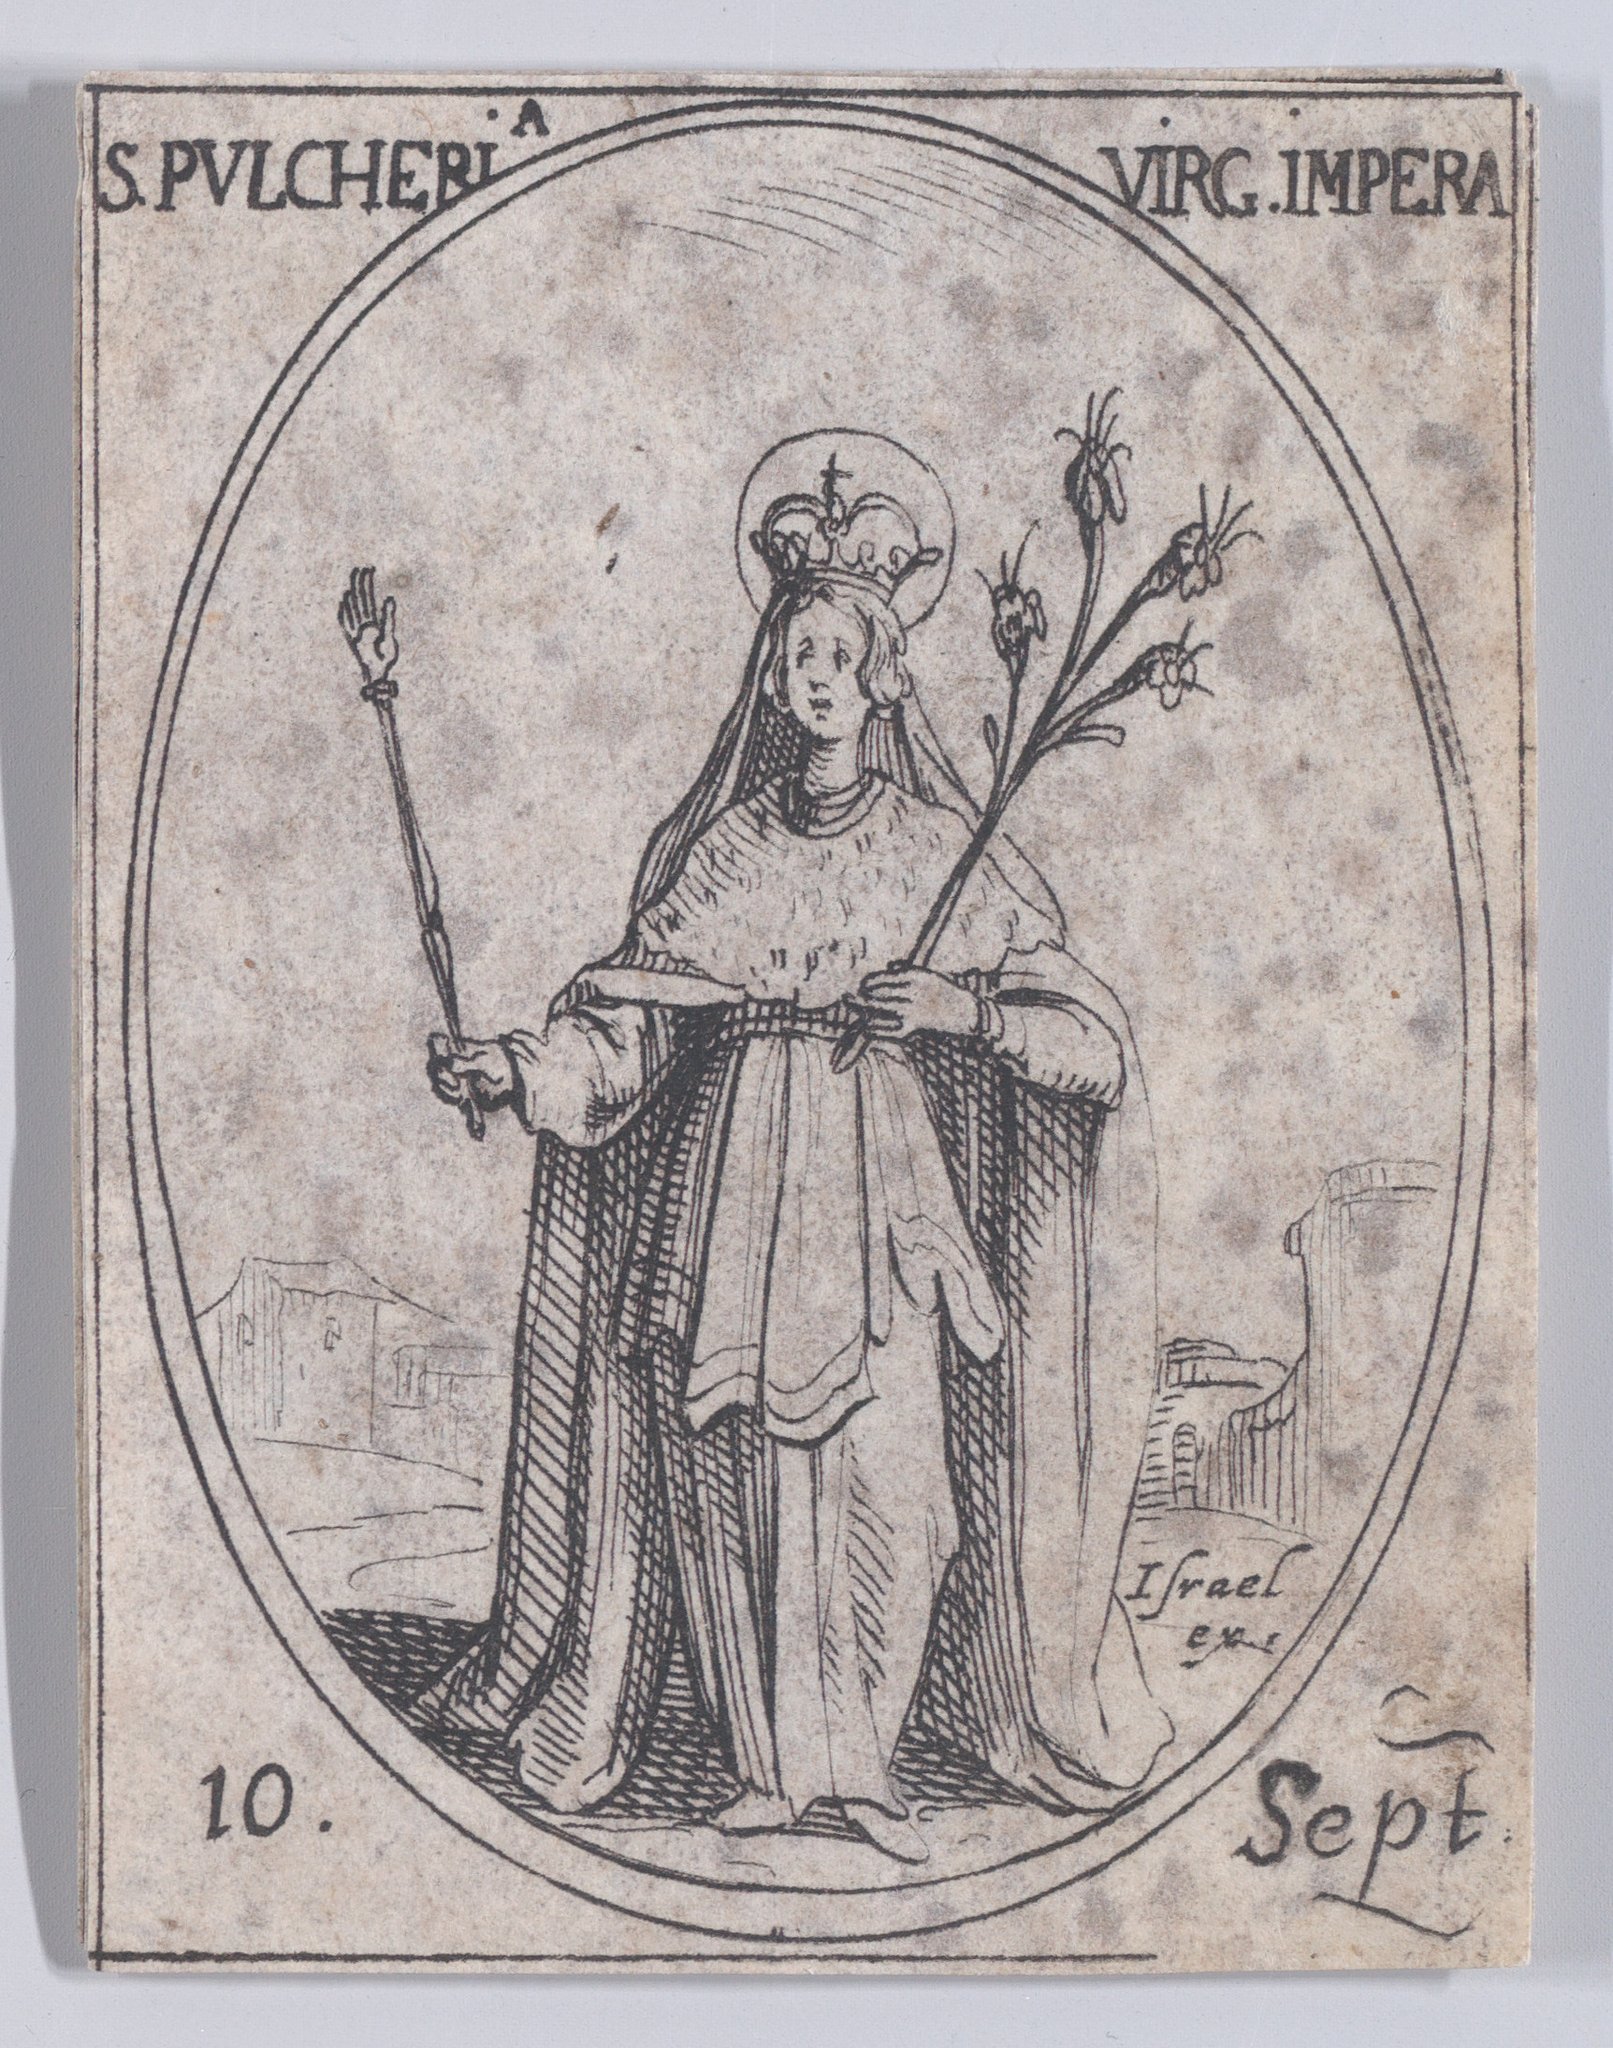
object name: print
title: Ste. Pulchérie, impératrice et vierge (St. Pulcheria, Empress and Virgin), September 10th, from "Les Images De Tous Les Saincts et Saintes de L'Année" (Images of All of the Saints and Religious Events of the Year)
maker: jacques callot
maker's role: artist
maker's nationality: french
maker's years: 1592-1635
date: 1636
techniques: etching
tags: women,saints